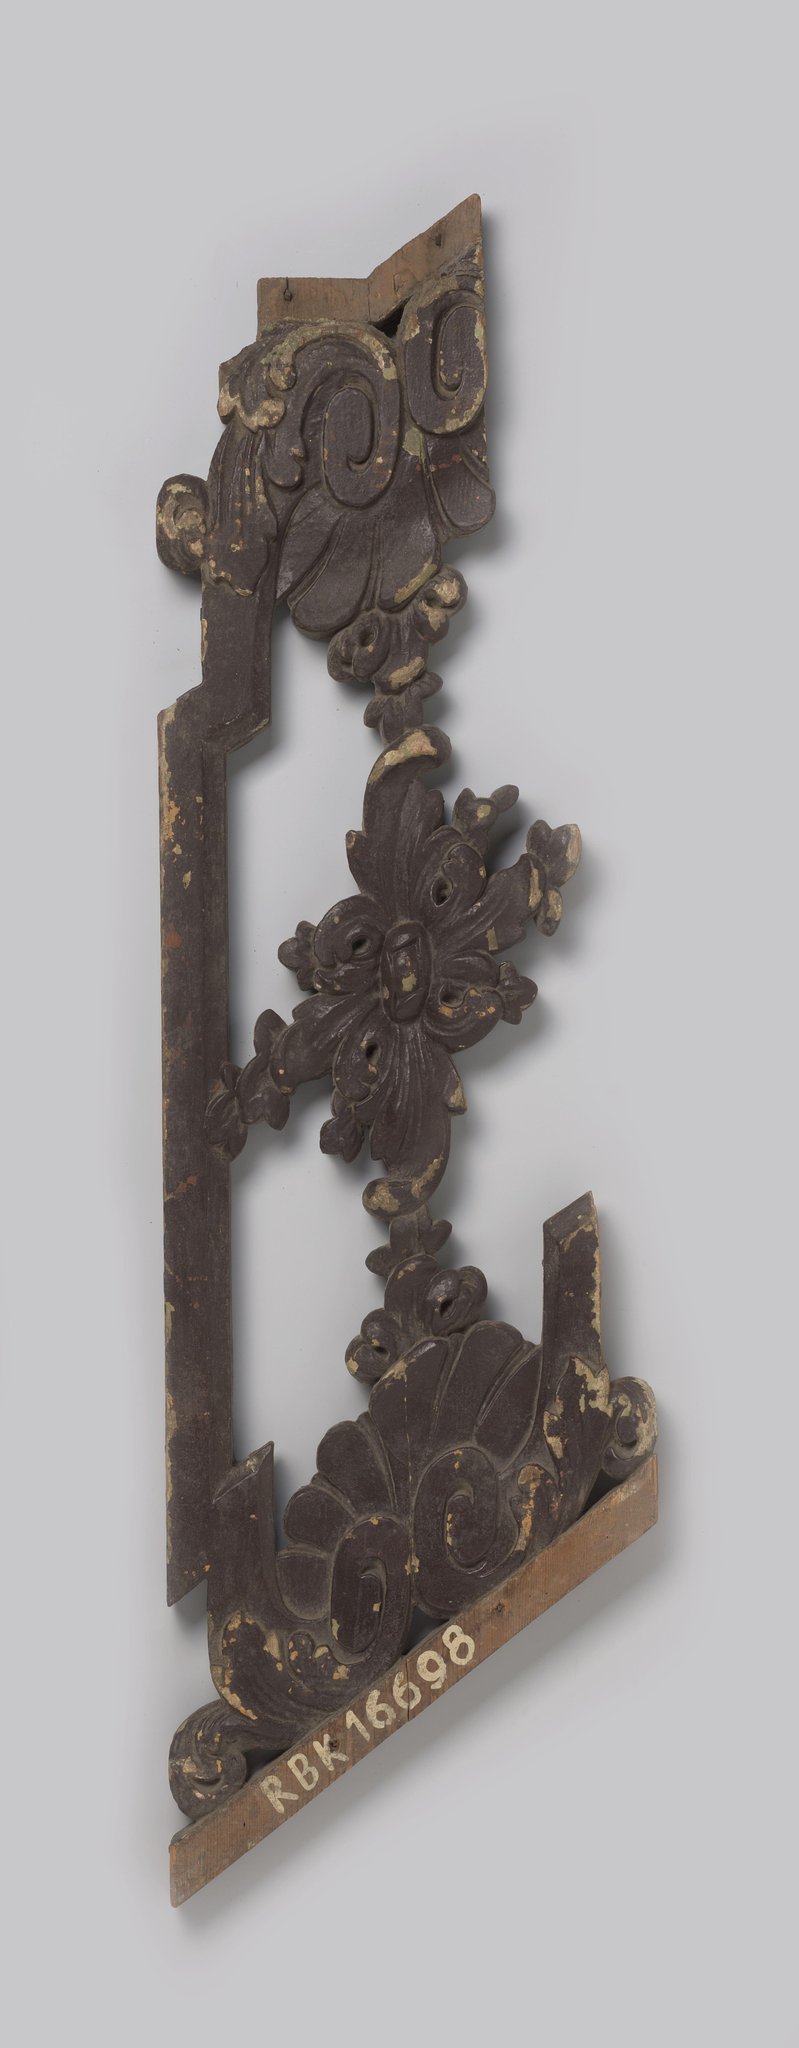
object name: baluster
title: Bouwfragment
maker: Anonymous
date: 1700-1725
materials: wood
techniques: painted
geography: northern netherlands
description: Een trapeziumvormige, opengewerkte trapbaluster van donkerbruin geverfd grenenhout. In het midden is een rozet aangebracht, en onder- en bovenaan voluten met schelp. Zie tevens: BK-16698-a/c.